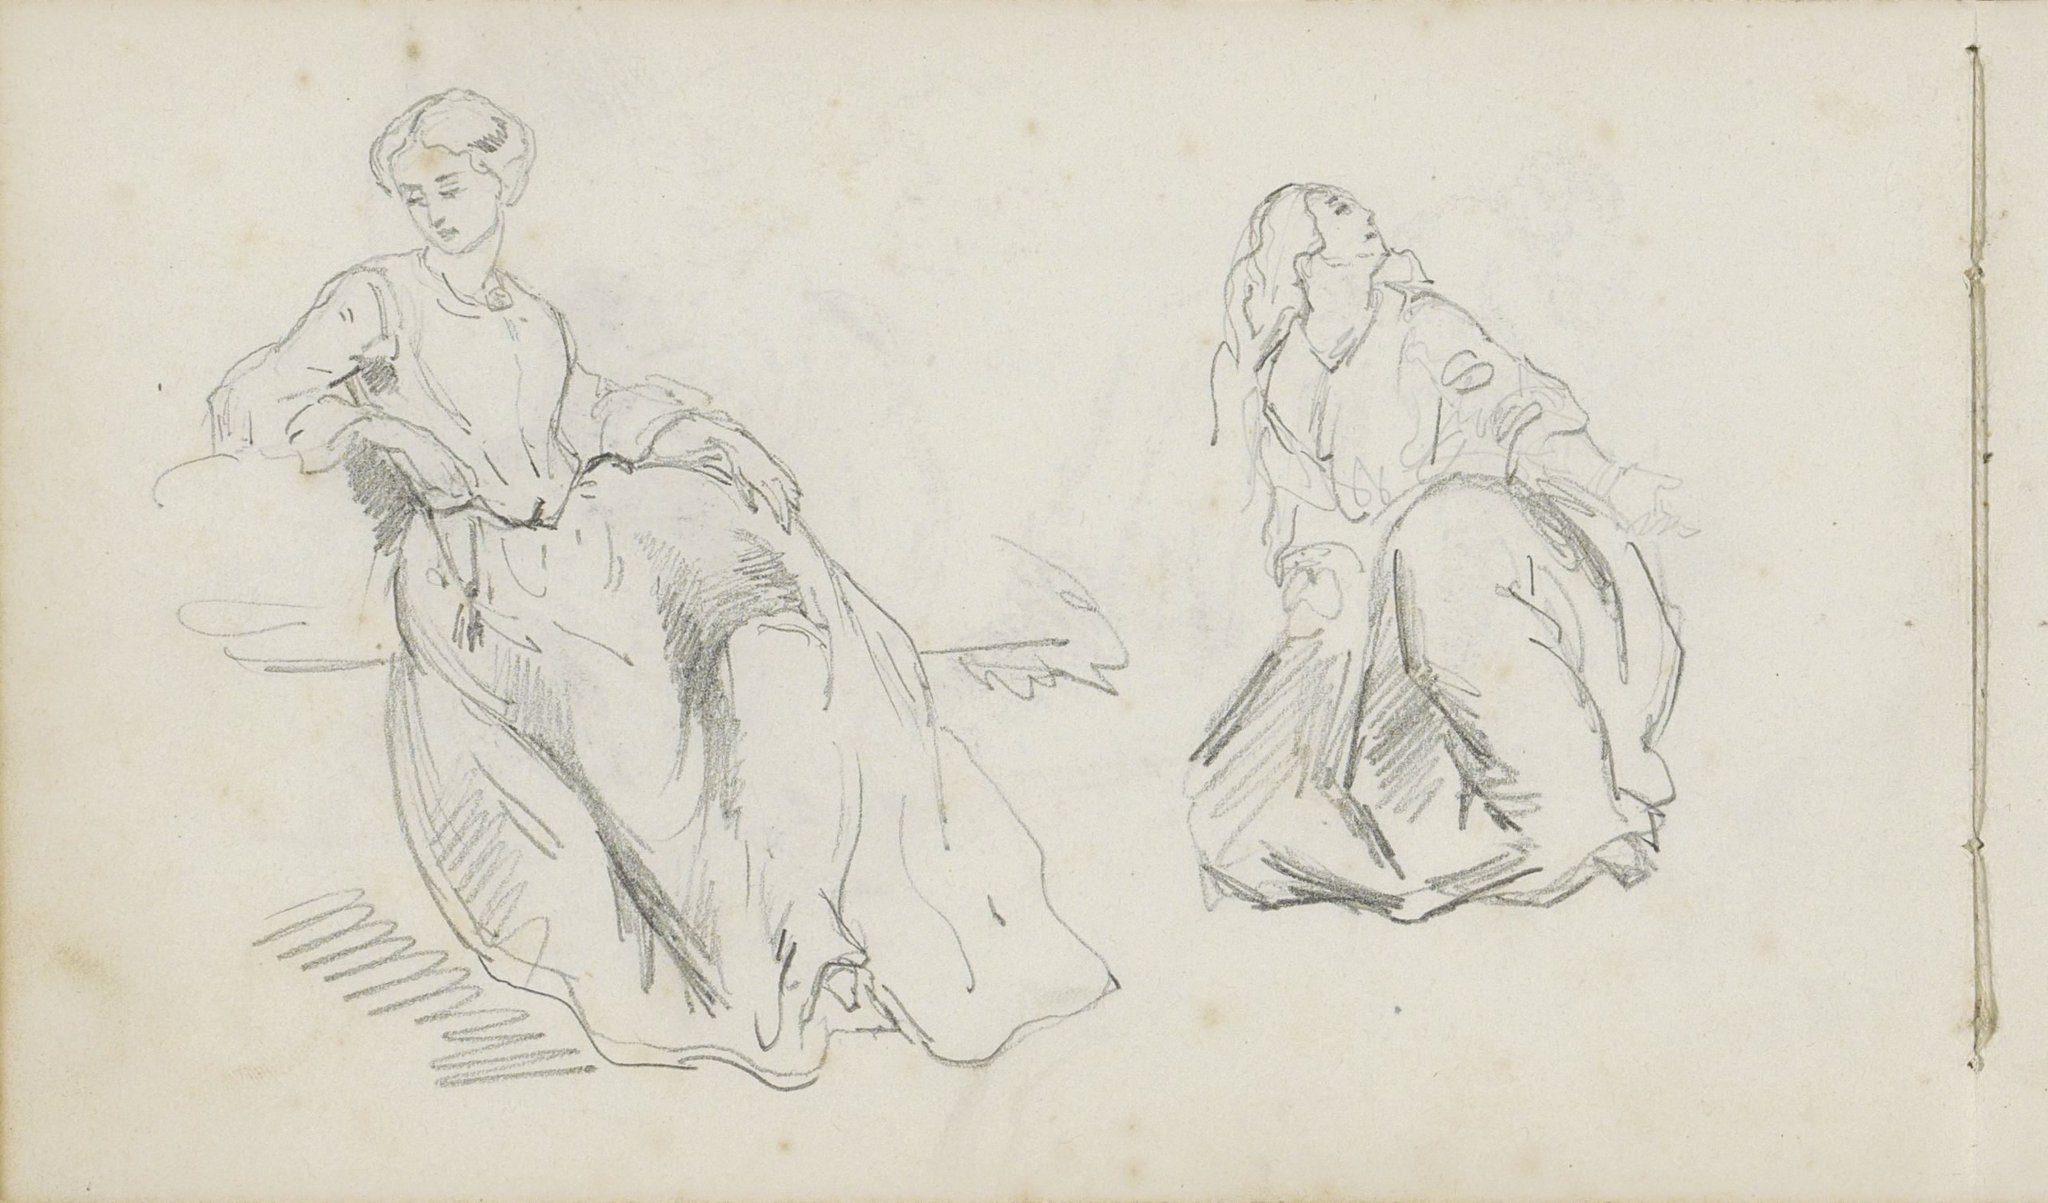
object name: sketchbook leaf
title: Zittende en een knielende vrouw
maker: charles rochussen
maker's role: draughtsman, painter, print maker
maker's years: 1814-1894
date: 1840-1860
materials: paper, pencil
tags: sitting figure - aa - female human figure, kneeling figure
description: Blad 3 verso uit een schetsboek met 38 bladen.